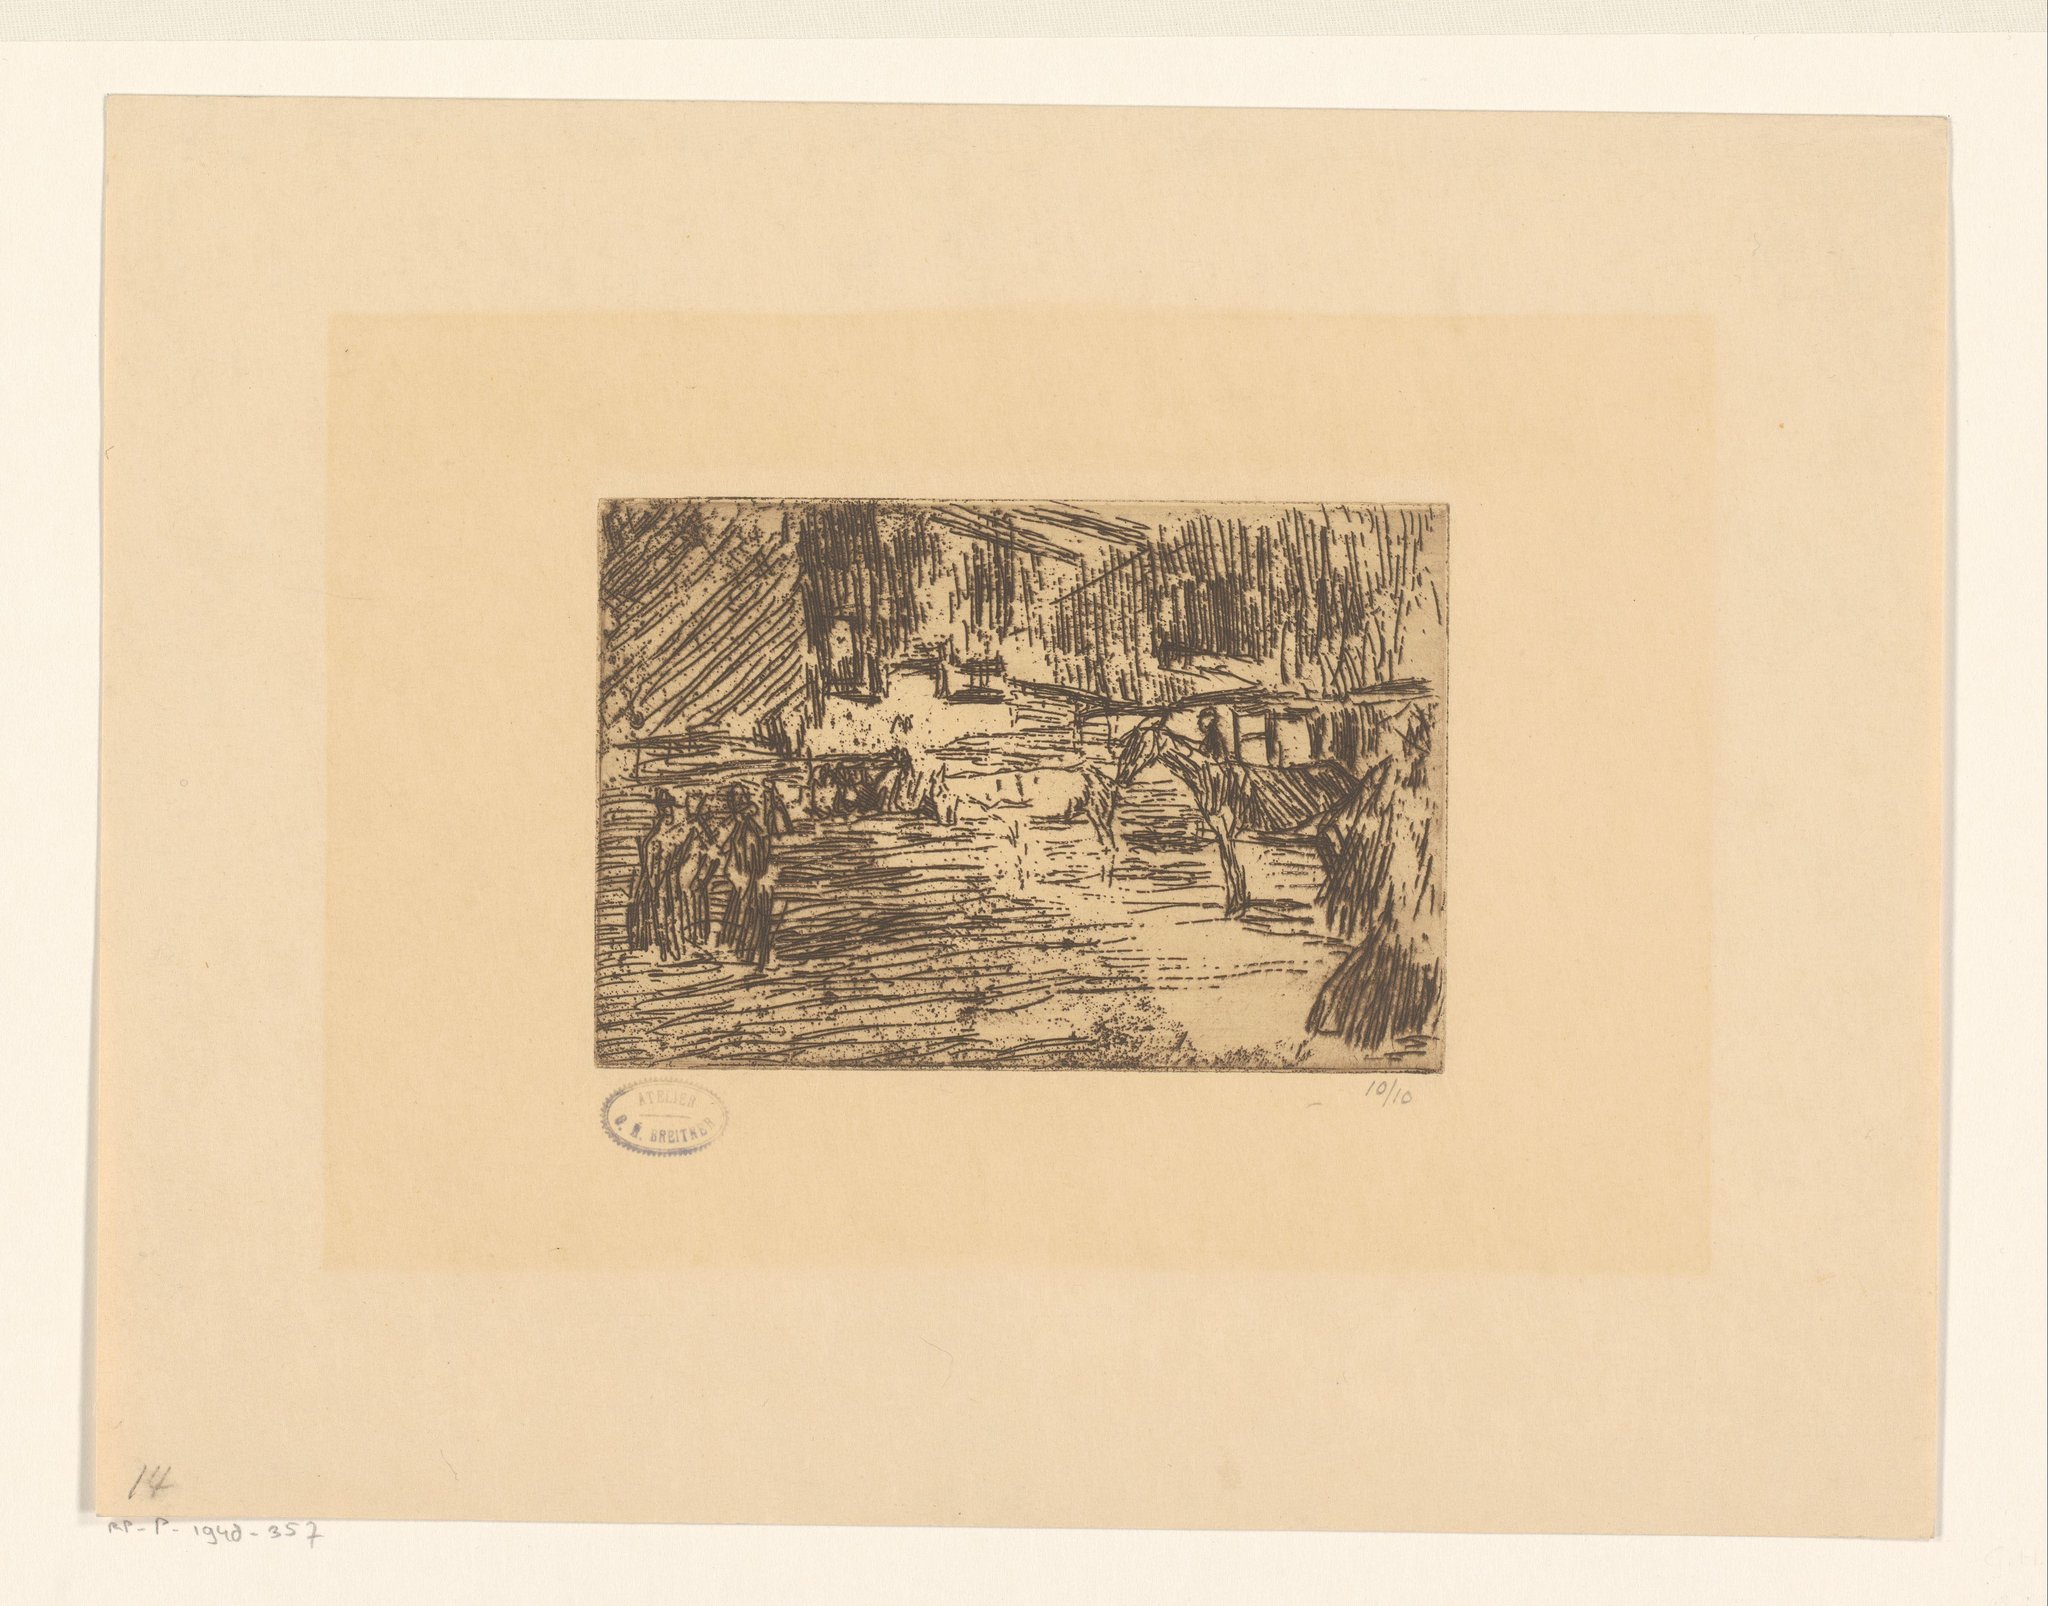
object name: print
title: Trampaarden (Leidseplein)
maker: george hendrik breitner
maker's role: draughtsman, painter, print maker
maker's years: 1857-1923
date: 1895-1900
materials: paper, ink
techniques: etching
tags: diligence, omnibus, horse-tram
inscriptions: collector's mark: Lugt 2228, workshop stamp: Lugt 291d, number: ‘14’, edition: ‘10/10’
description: Rechts paarden en tramwagons, links enkele figuren; schetsmatig weergegeven.